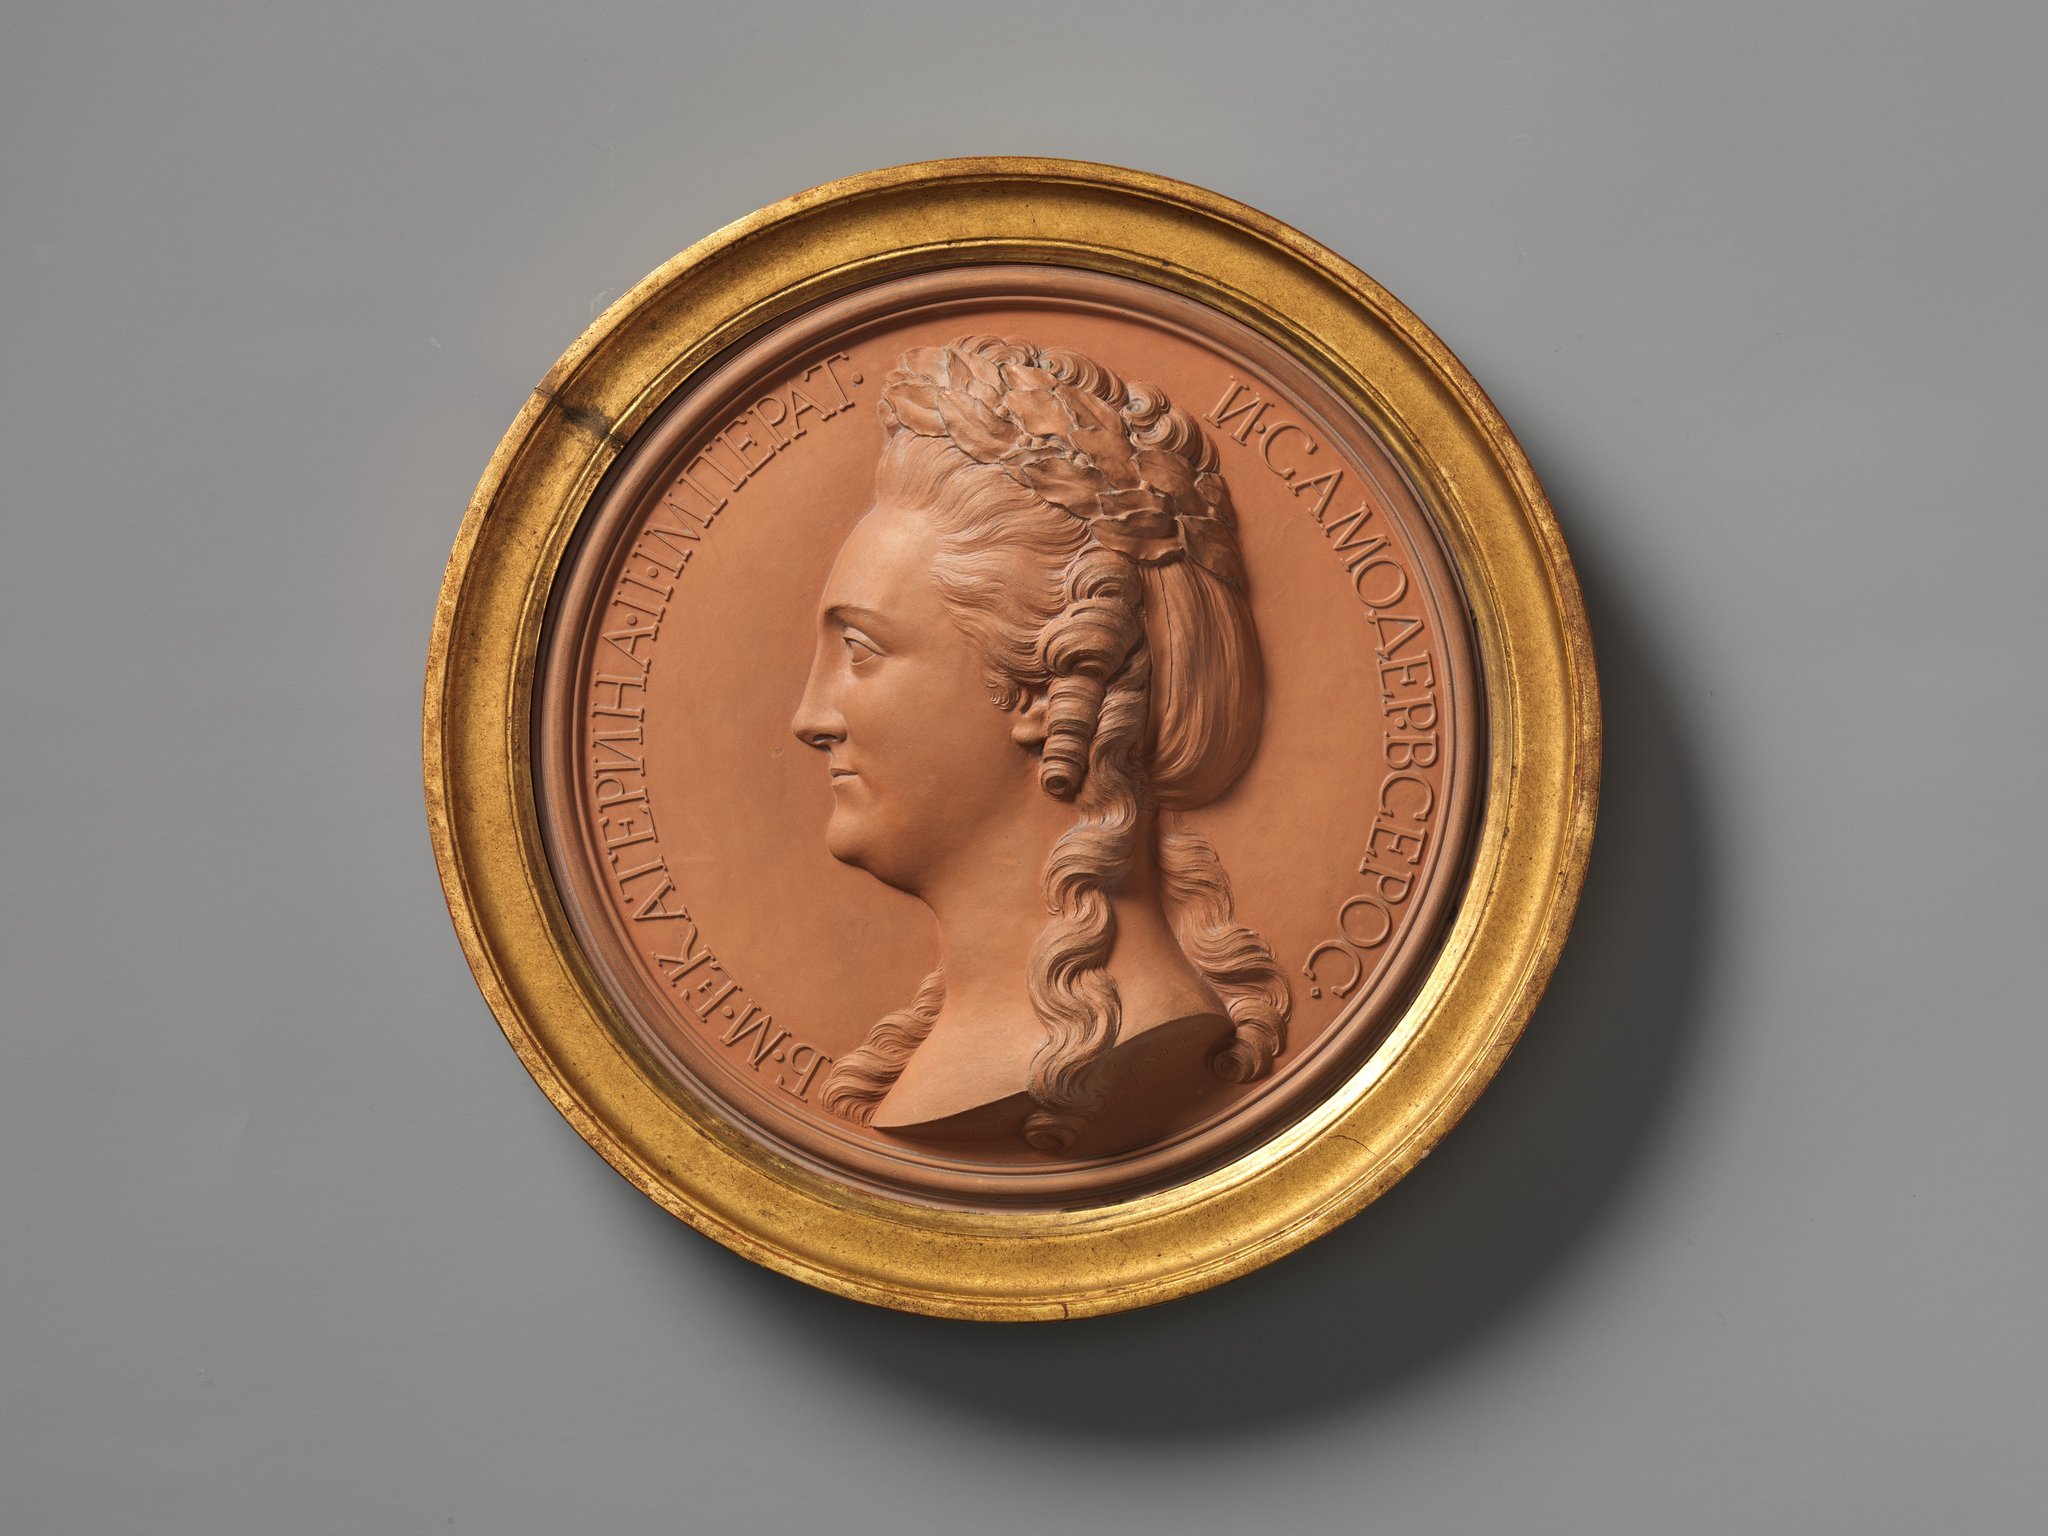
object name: medallion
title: Catherine II The Great, Empress of Russia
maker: jean-baptiste nini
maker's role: artist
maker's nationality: italian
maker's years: 1717-1786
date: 1771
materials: gilt, terracotta, wood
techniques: casting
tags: portraits,profiles,women